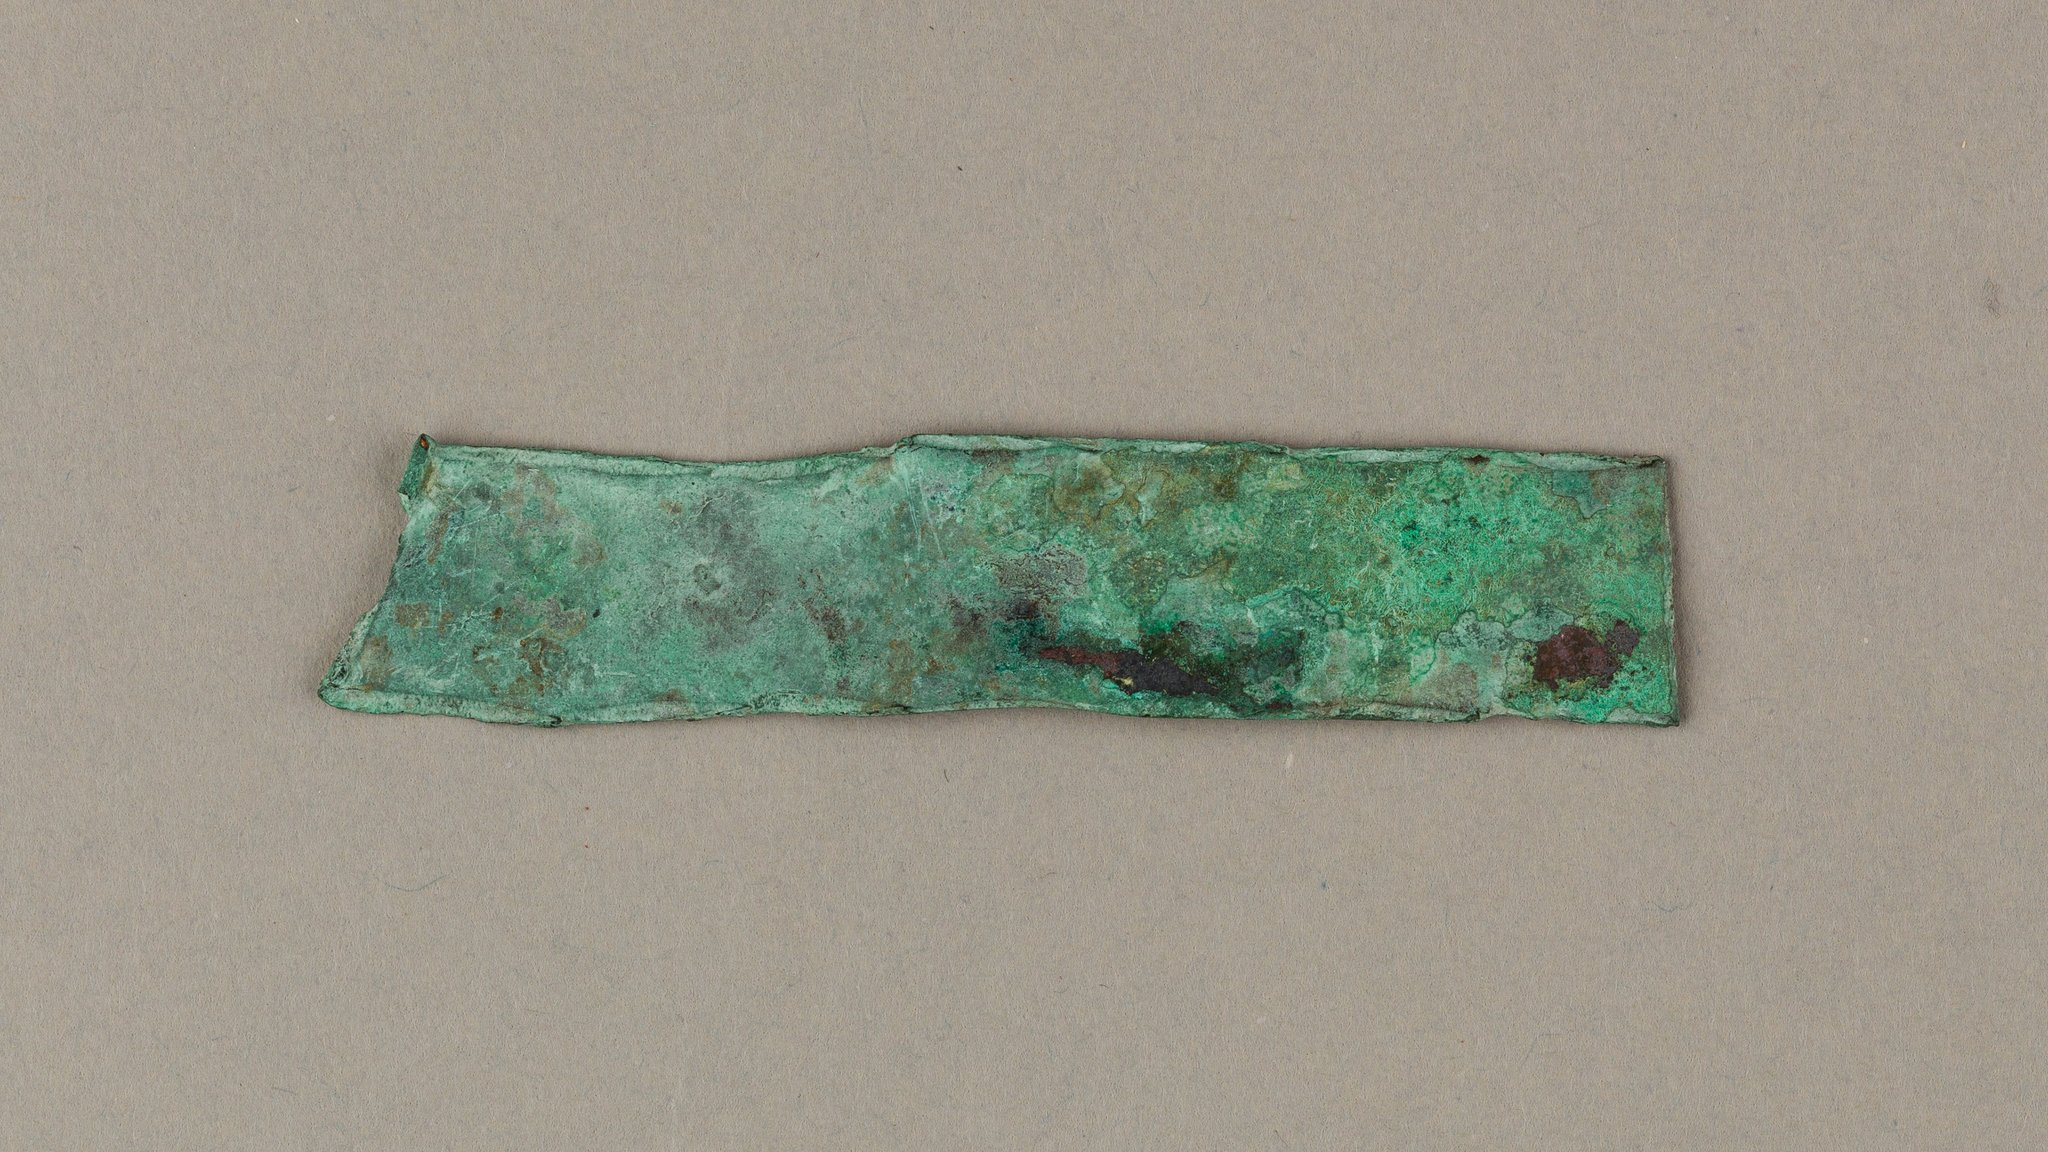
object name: model chisel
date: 2650 BCE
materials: copper alloy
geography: egypt